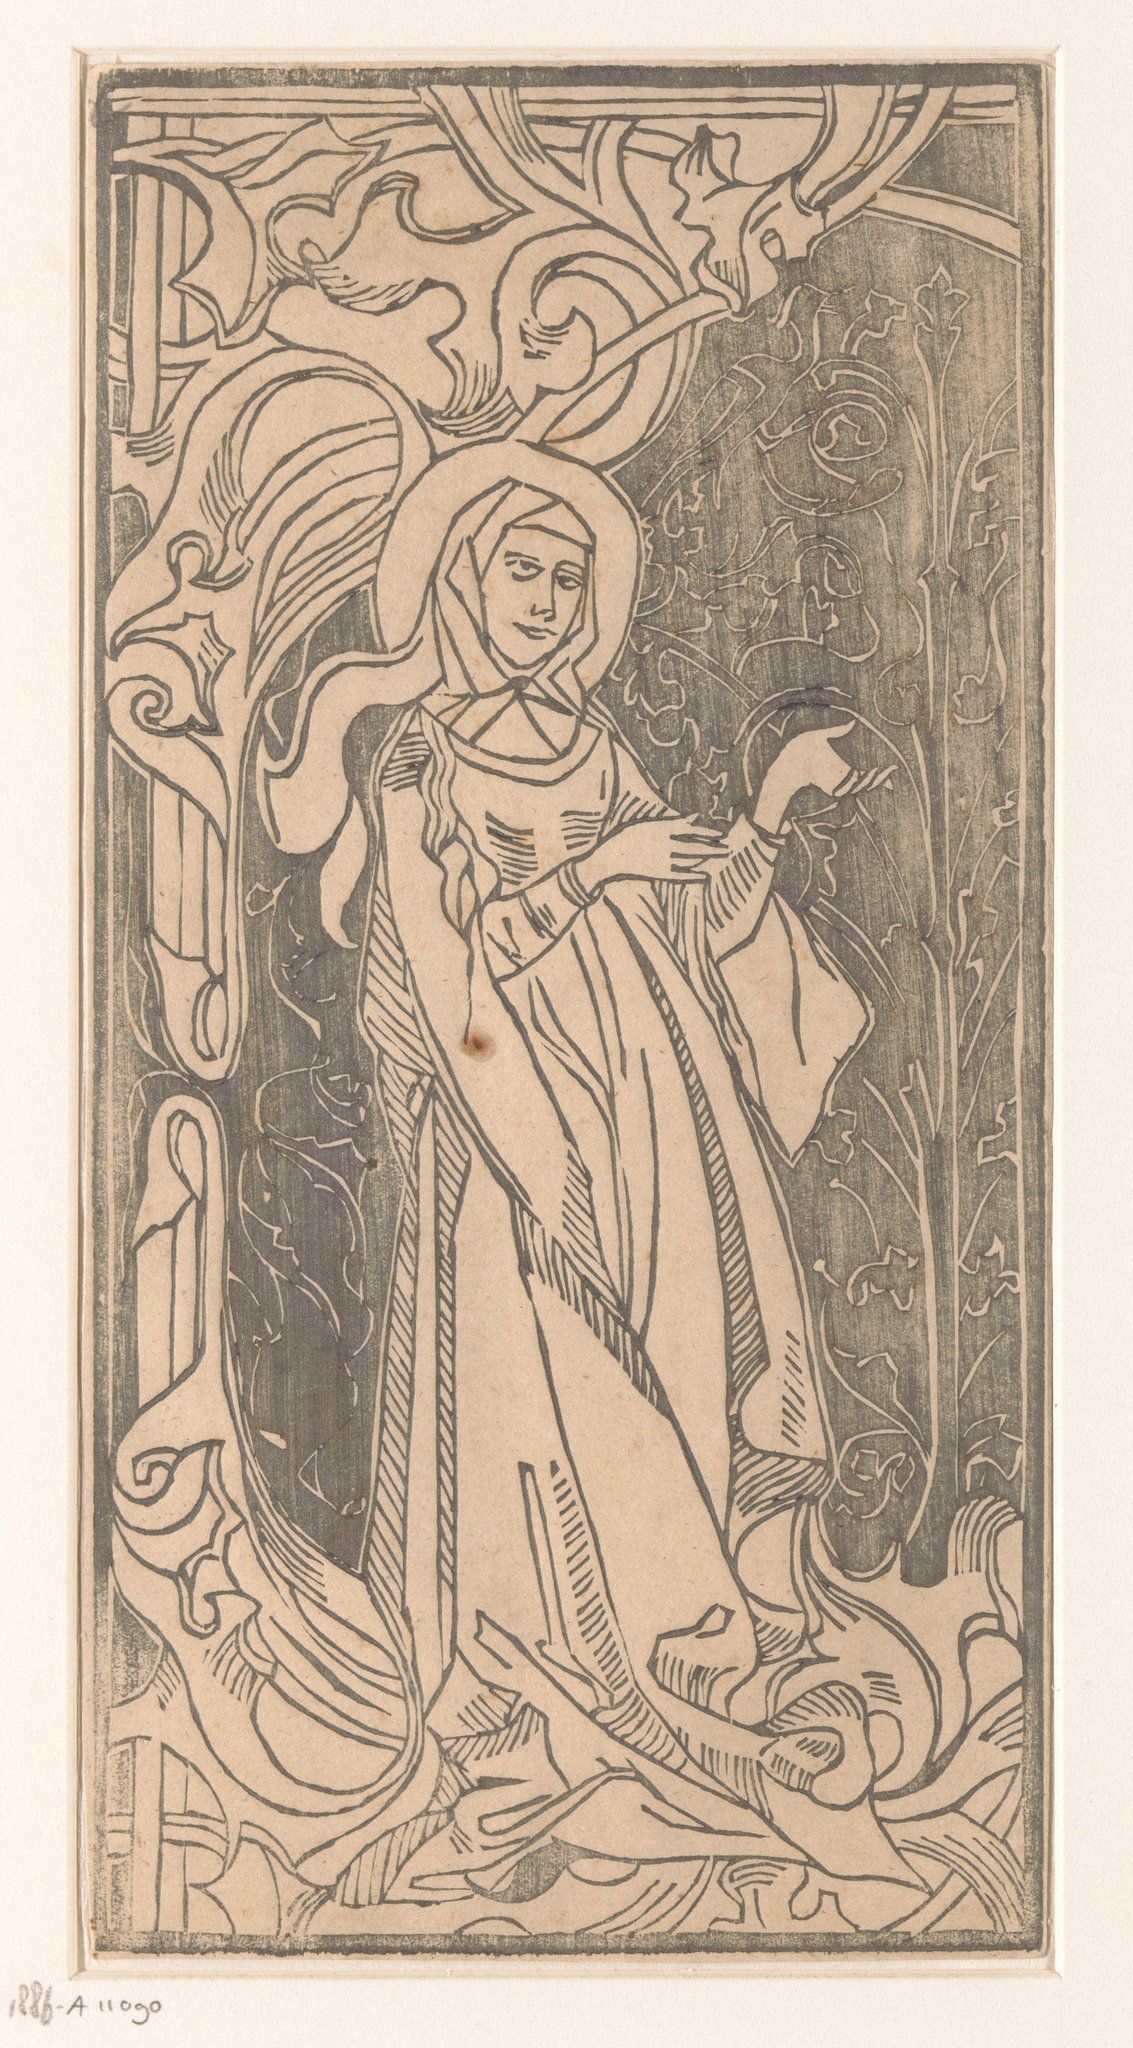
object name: print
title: Houtsneden in middeleeuwse stijl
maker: Anonymous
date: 1800-1886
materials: paper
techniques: woodcut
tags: female saints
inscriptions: collector's mark: Lugt 2228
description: Onderdeel van een reeks van drie houtsneden in middeleeuwse stijl.